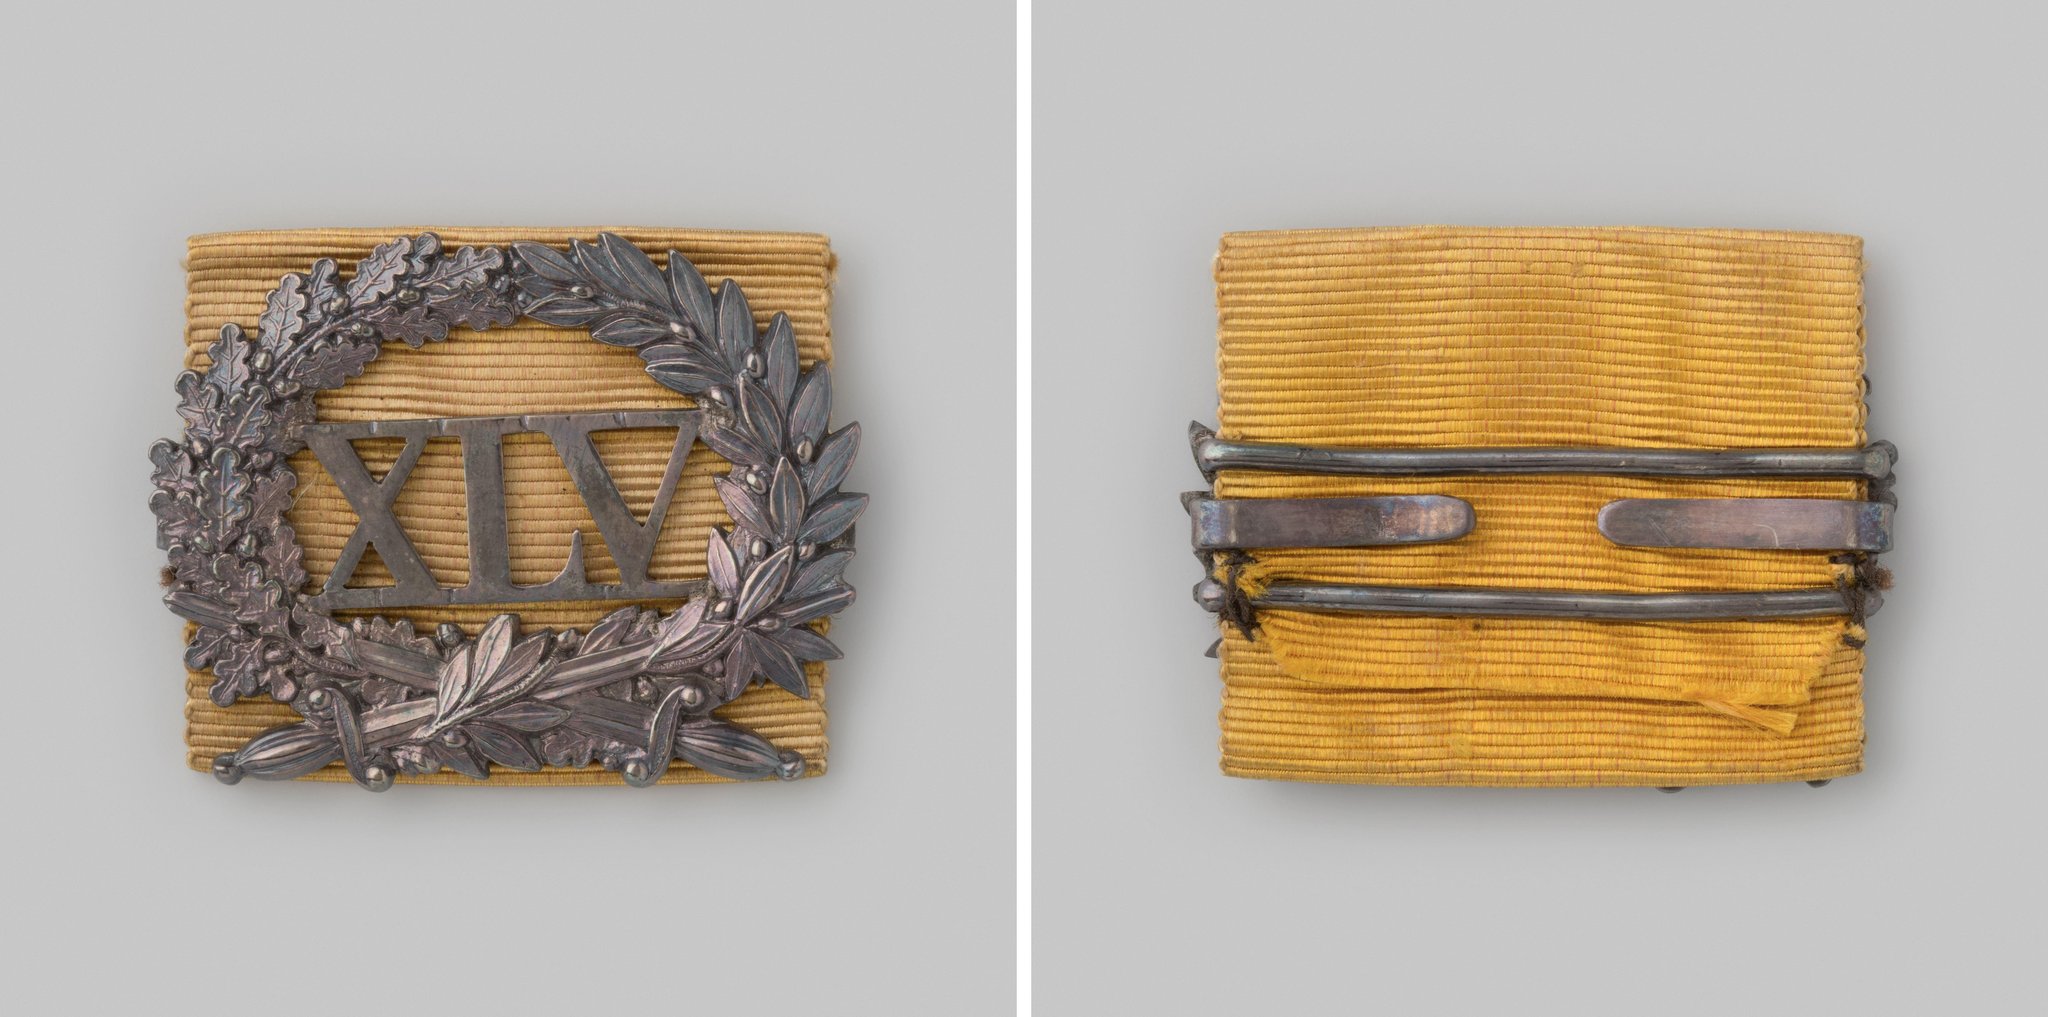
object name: insignia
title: Ereteken (gesp) voor vijfenveertig jaar eervolle, langdurige en werkelijke dienst bij de schutterij als officier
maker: Anonymous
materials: silver, textile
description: Zilveren draagteken in de vorm van een gesp op lint.